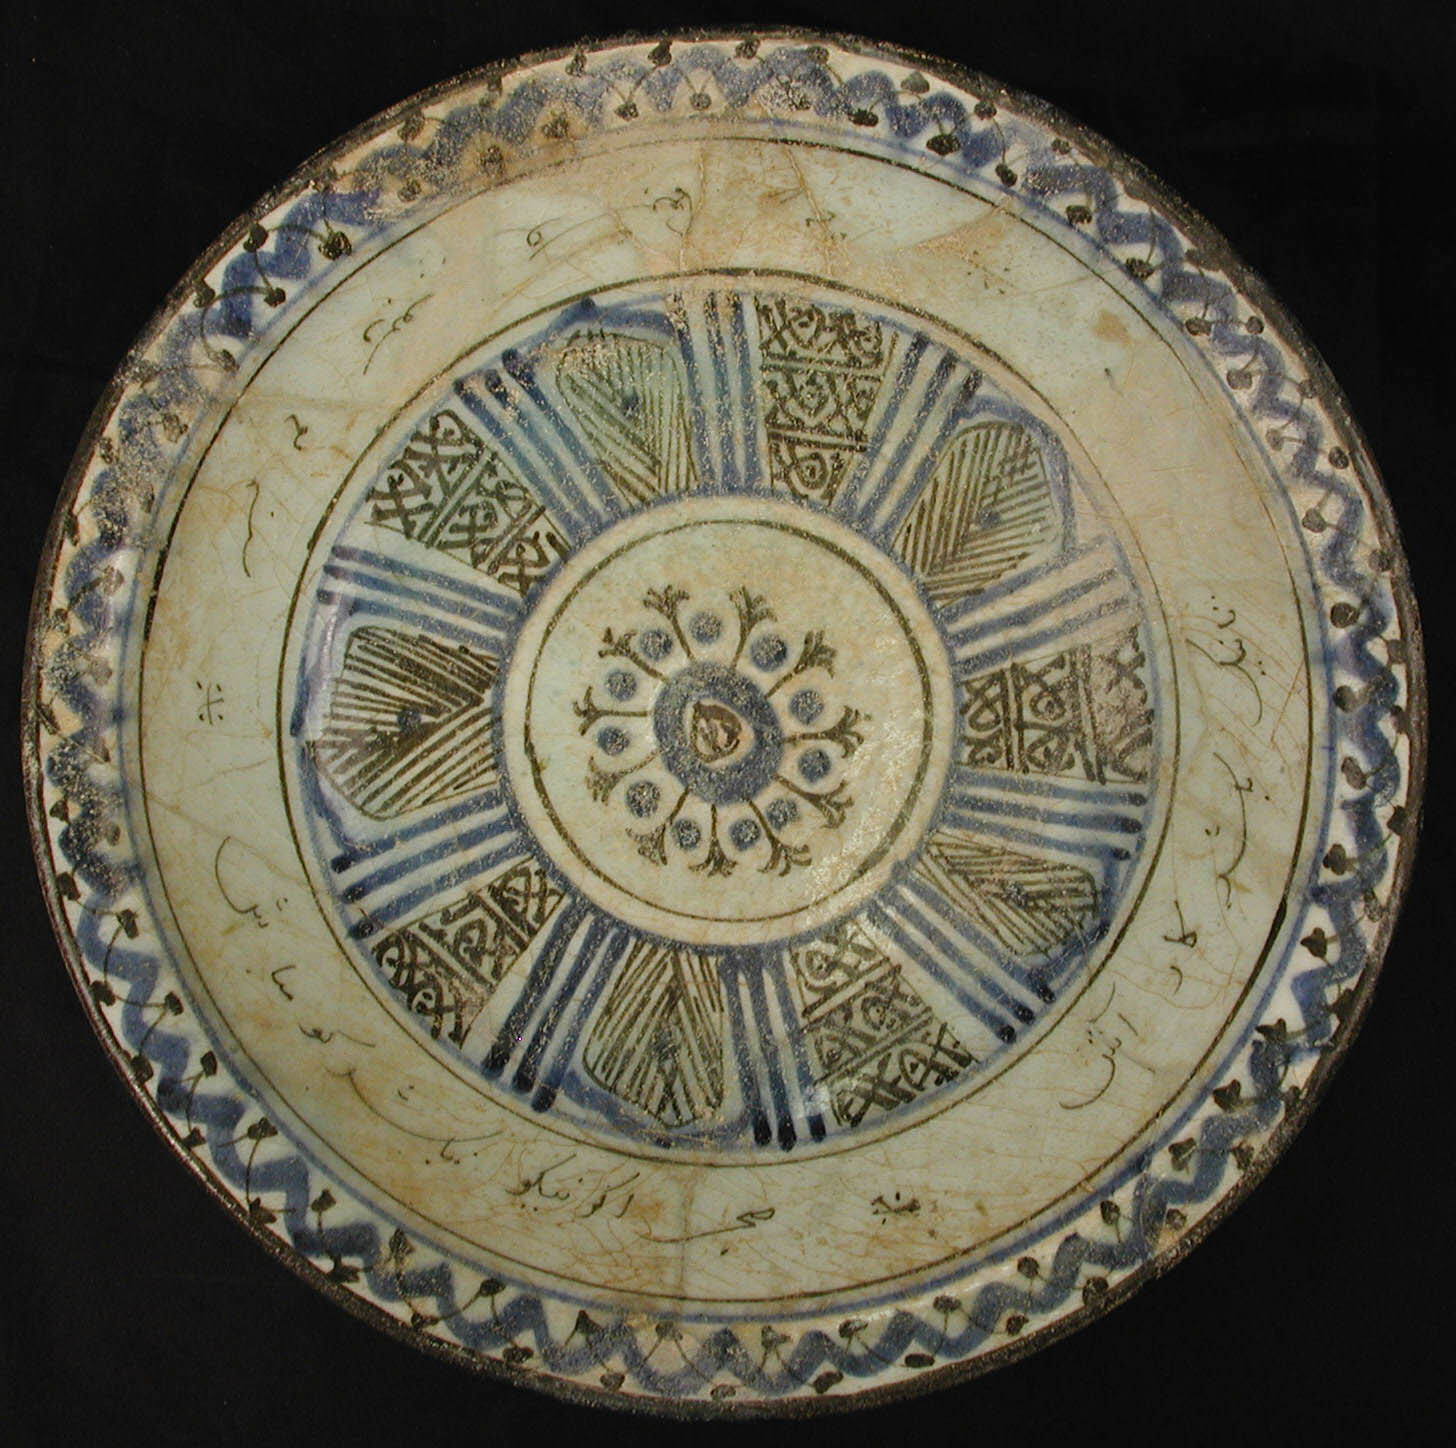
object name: bowl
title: Bowl with Persian Inscription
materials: glaze, stonepaste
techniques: painting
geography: iran